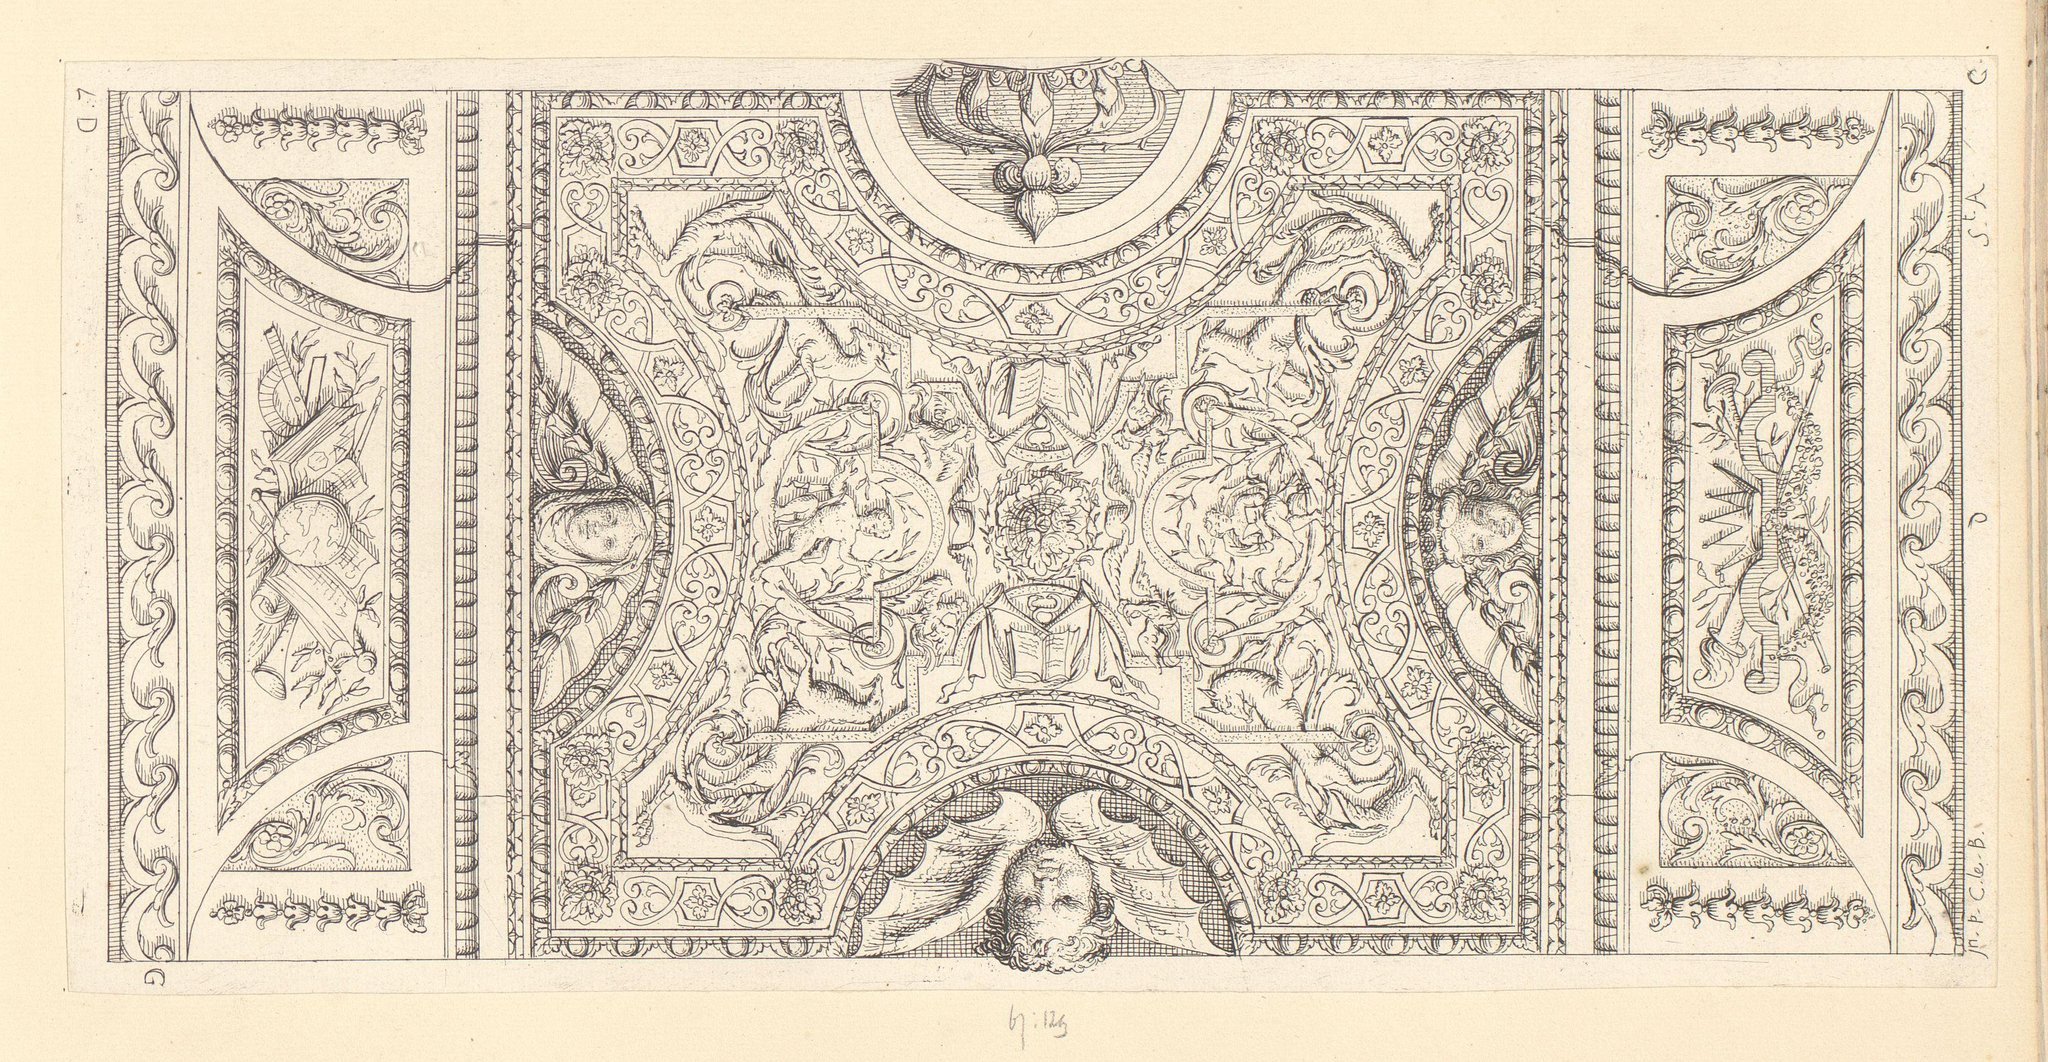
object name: album leaf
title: Werken van Charles le Brun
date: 1695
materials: paper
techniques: etching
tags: ornaments ~ art, (decorated) ceiling, paris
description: Deze prent maakt deel uit van een album.